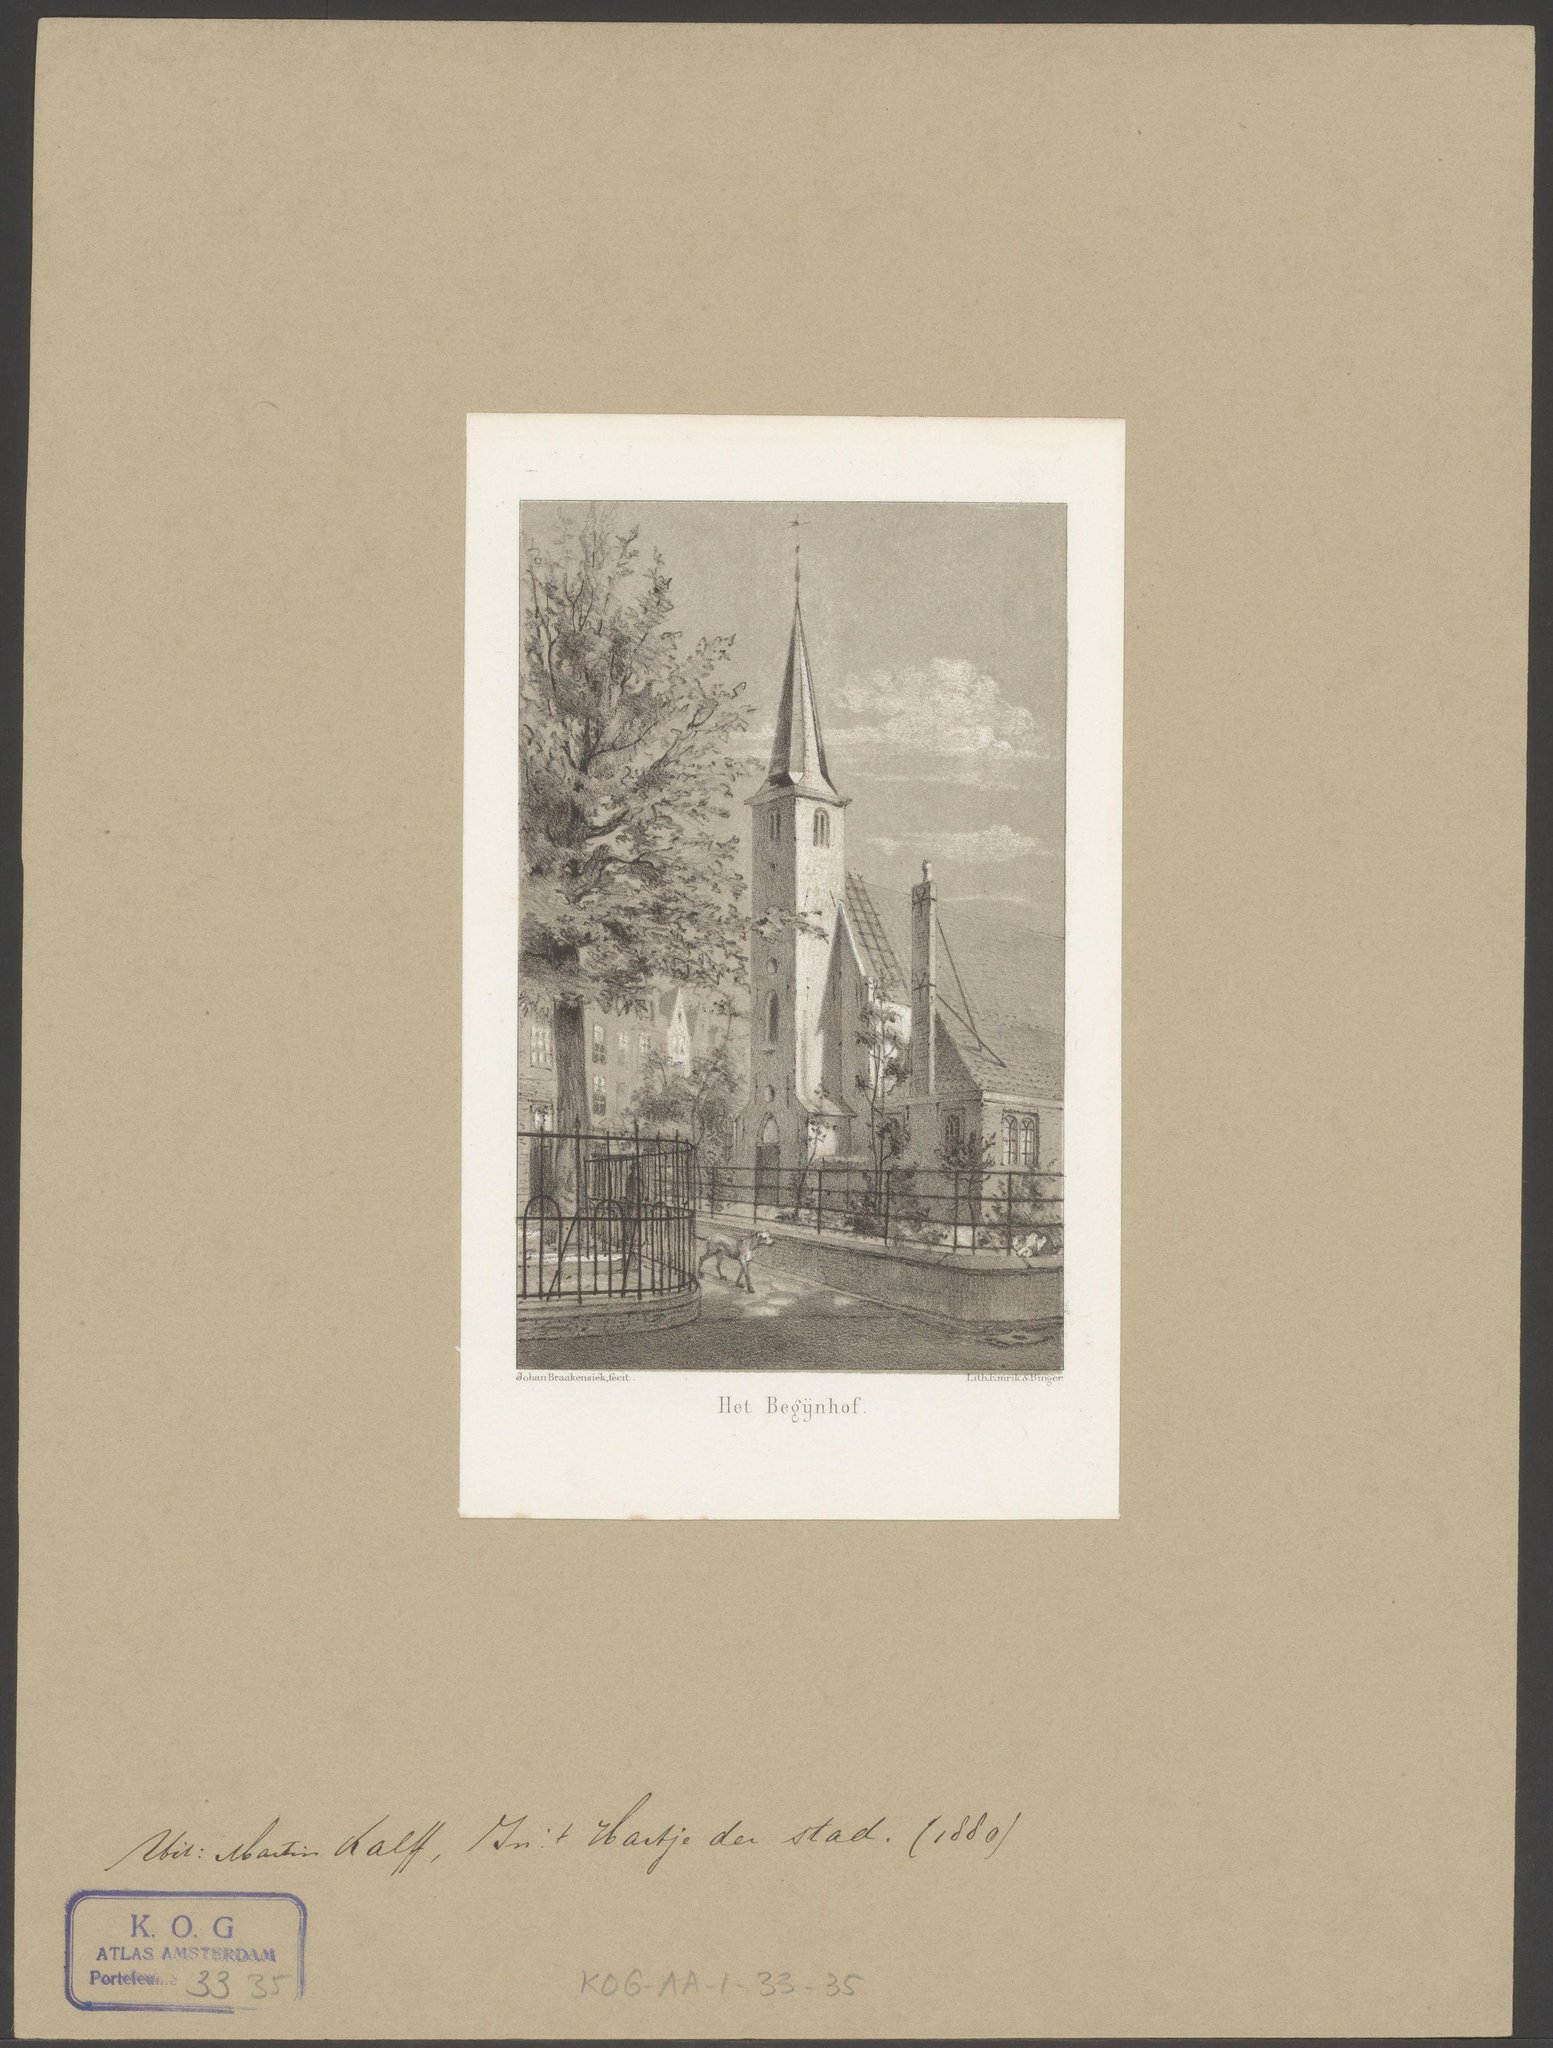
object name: book illustration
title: Gezicht op de Engelse Kerk te Amsterdam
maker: johan braakensiek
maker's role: draughtsman, print maker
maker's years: 1858-1940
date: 1880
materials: paper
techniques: tone lithography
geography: netherlands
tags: church (exterior), street (+ city(-scape) with figures, staffage)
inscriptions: collector's mark: Lugt 1641b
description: Prent uit: Kalff, Martin. In 't hartje der stad. Oud en nieuw Amsterdam. Amsterdam: Amsterdamsche Courant, [1880].